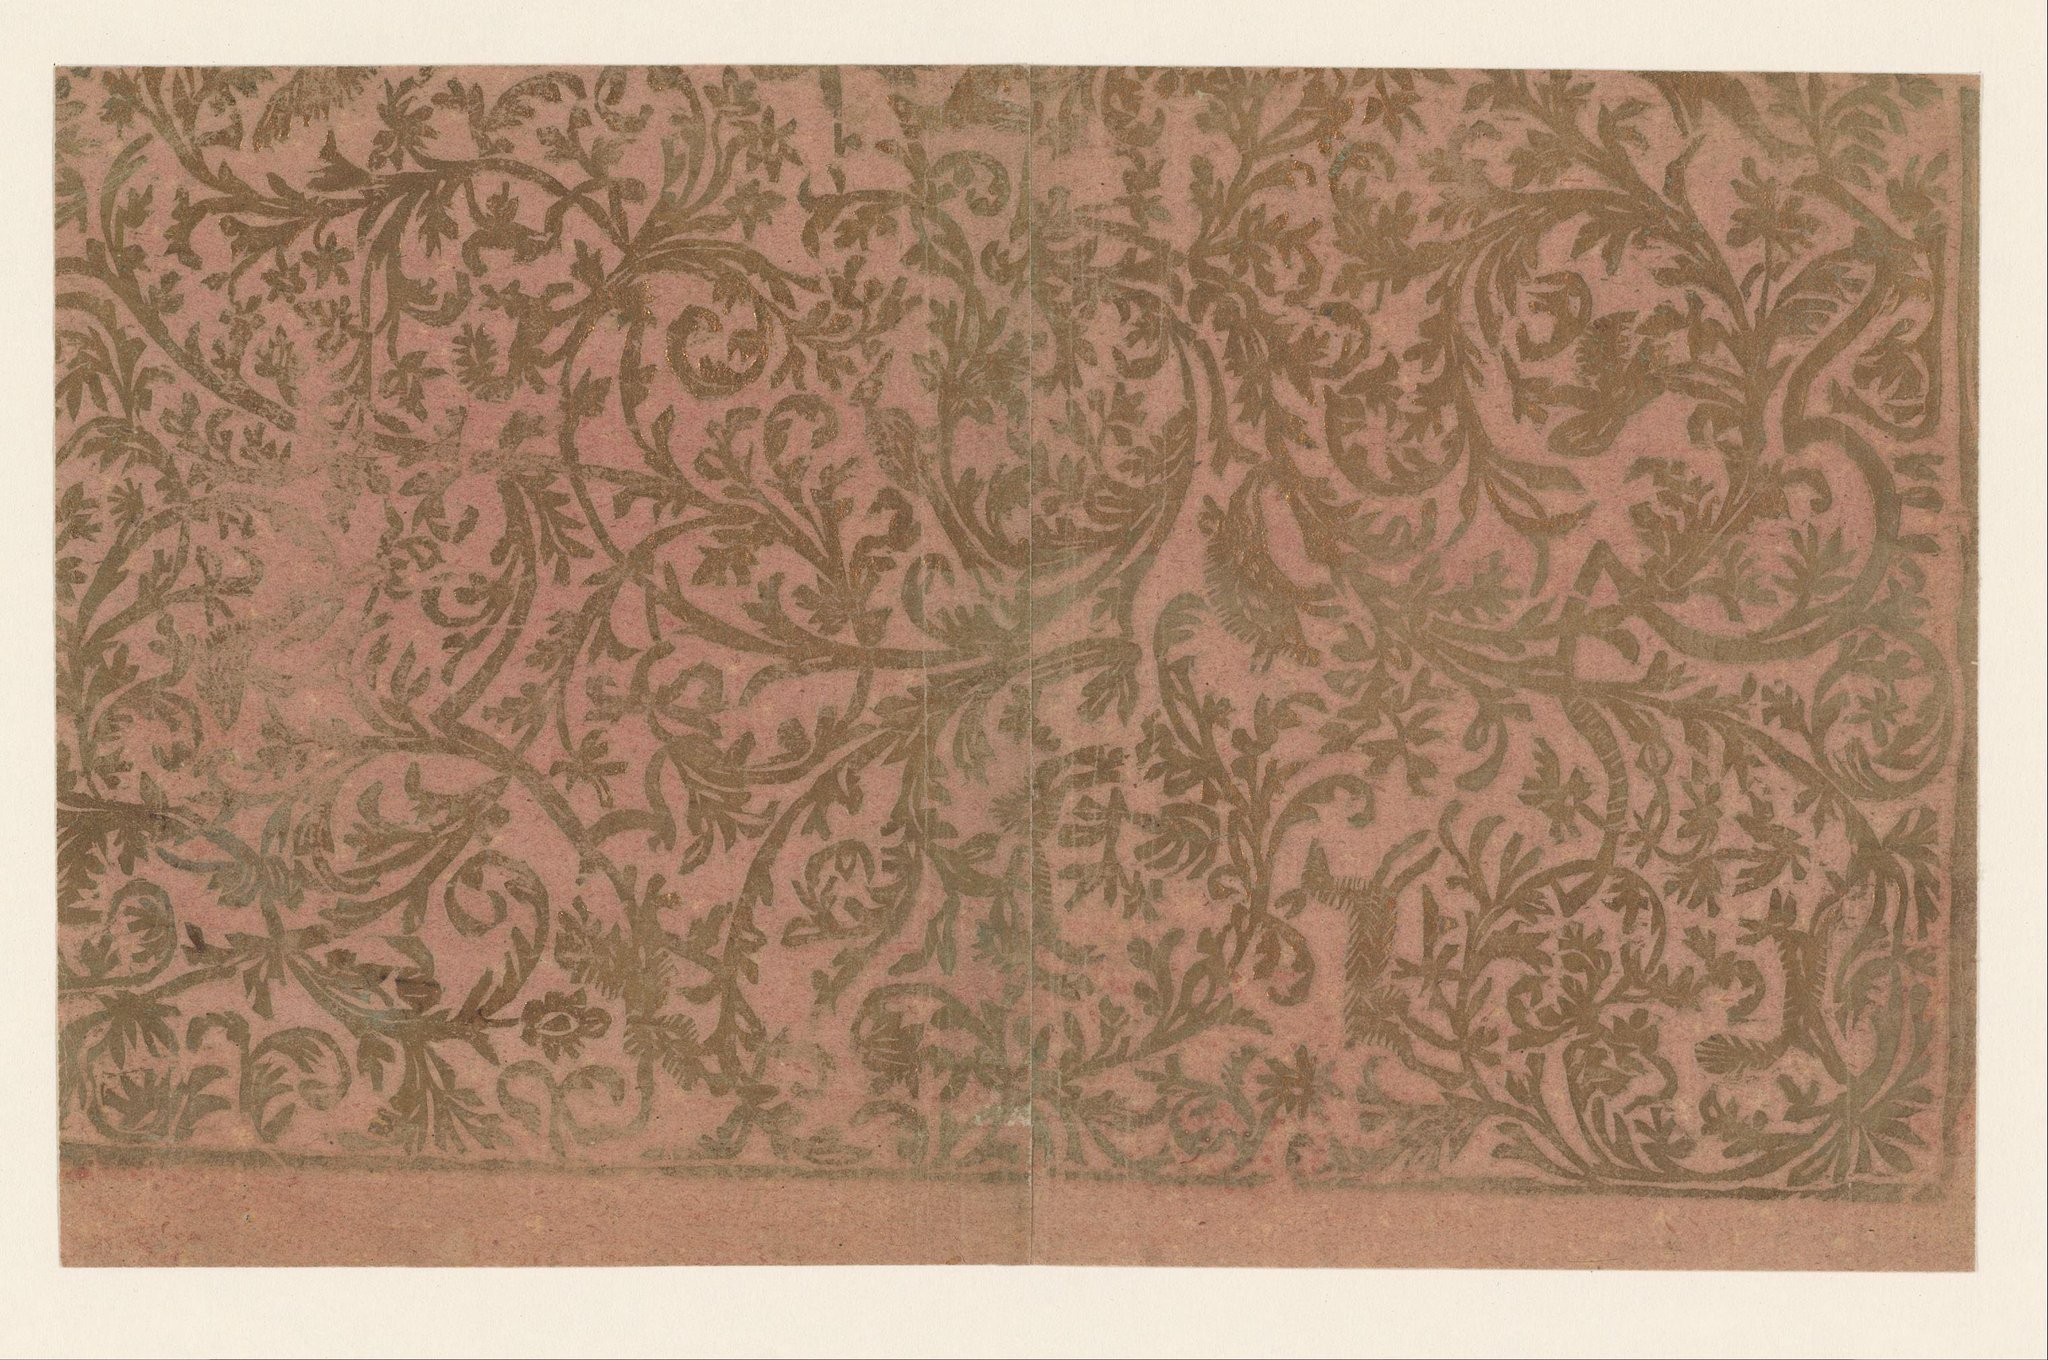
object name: wrapper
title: Blad met patroon van dieren tussen bladranken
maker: Anonymous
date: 1730-1770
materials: gold leaf, paper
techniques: relief print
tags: ornament derived from animal forms, ornament derived from plant forms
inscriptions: annotation: ‘1750 / Lugossy O. 1750 Debr. 3885’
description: Blad met patroon van dieren (zwijn, hert, hond, vogels) tussen bladranken. Gebruikt als omslag voor een publicatie uit 1750.